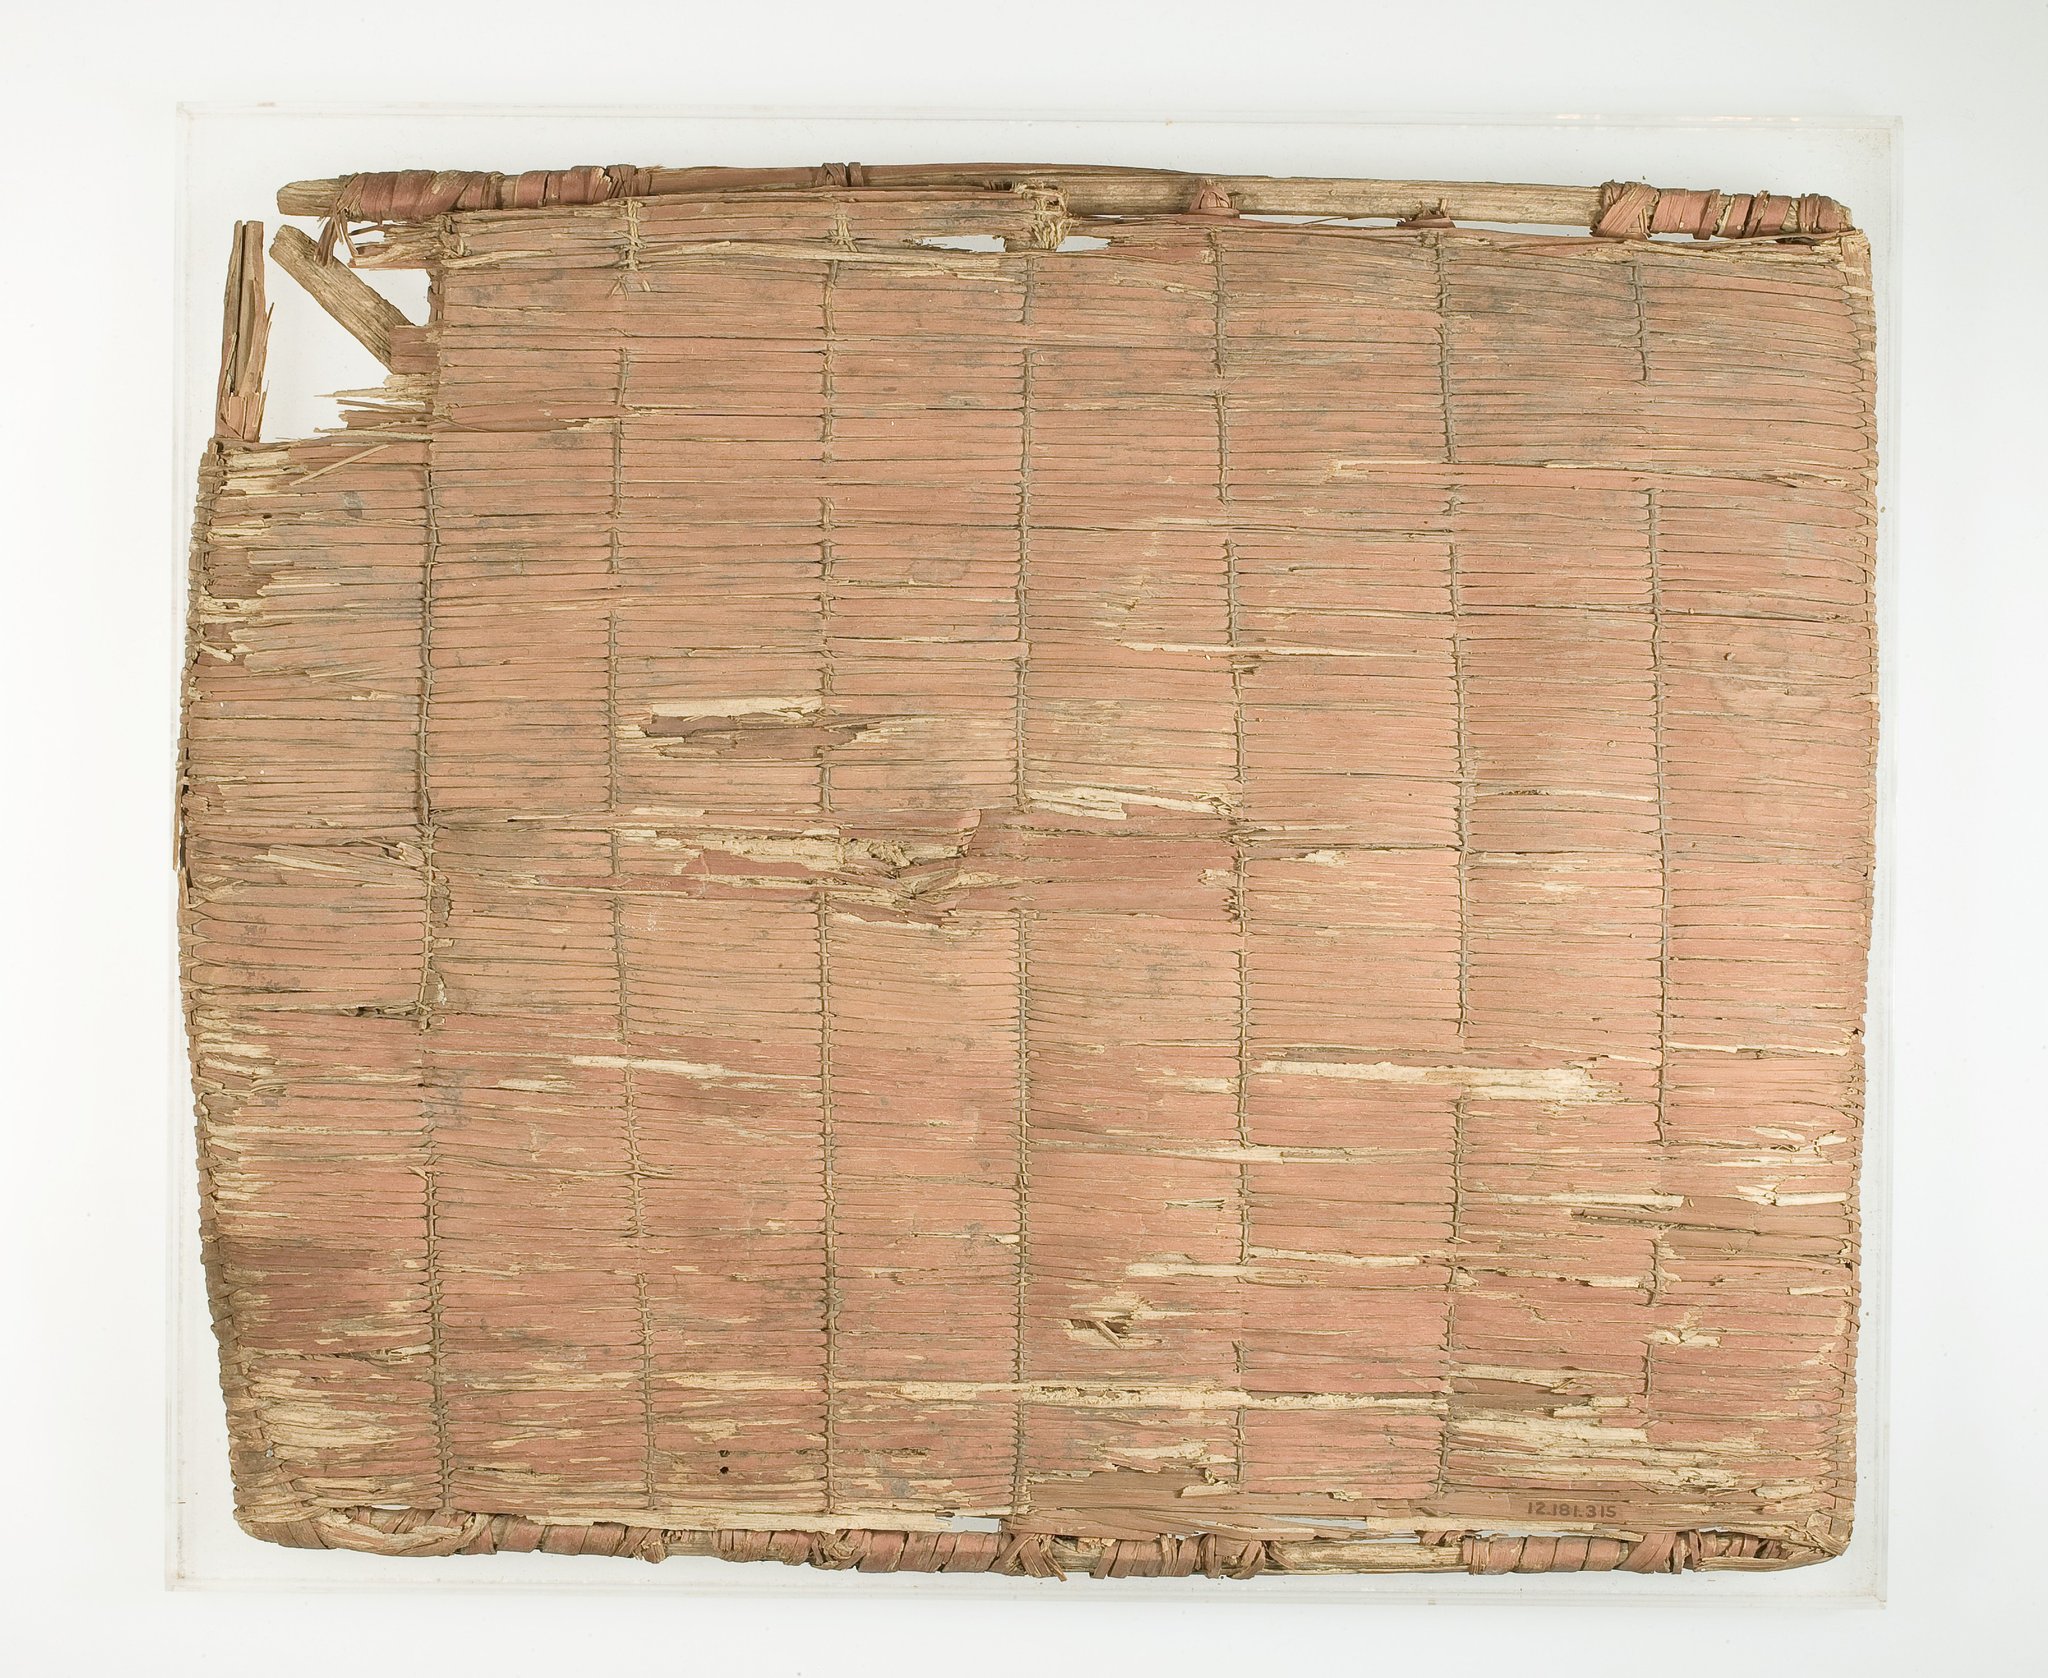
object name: mat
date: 1550-1295 BCE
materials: fiber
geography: egypt